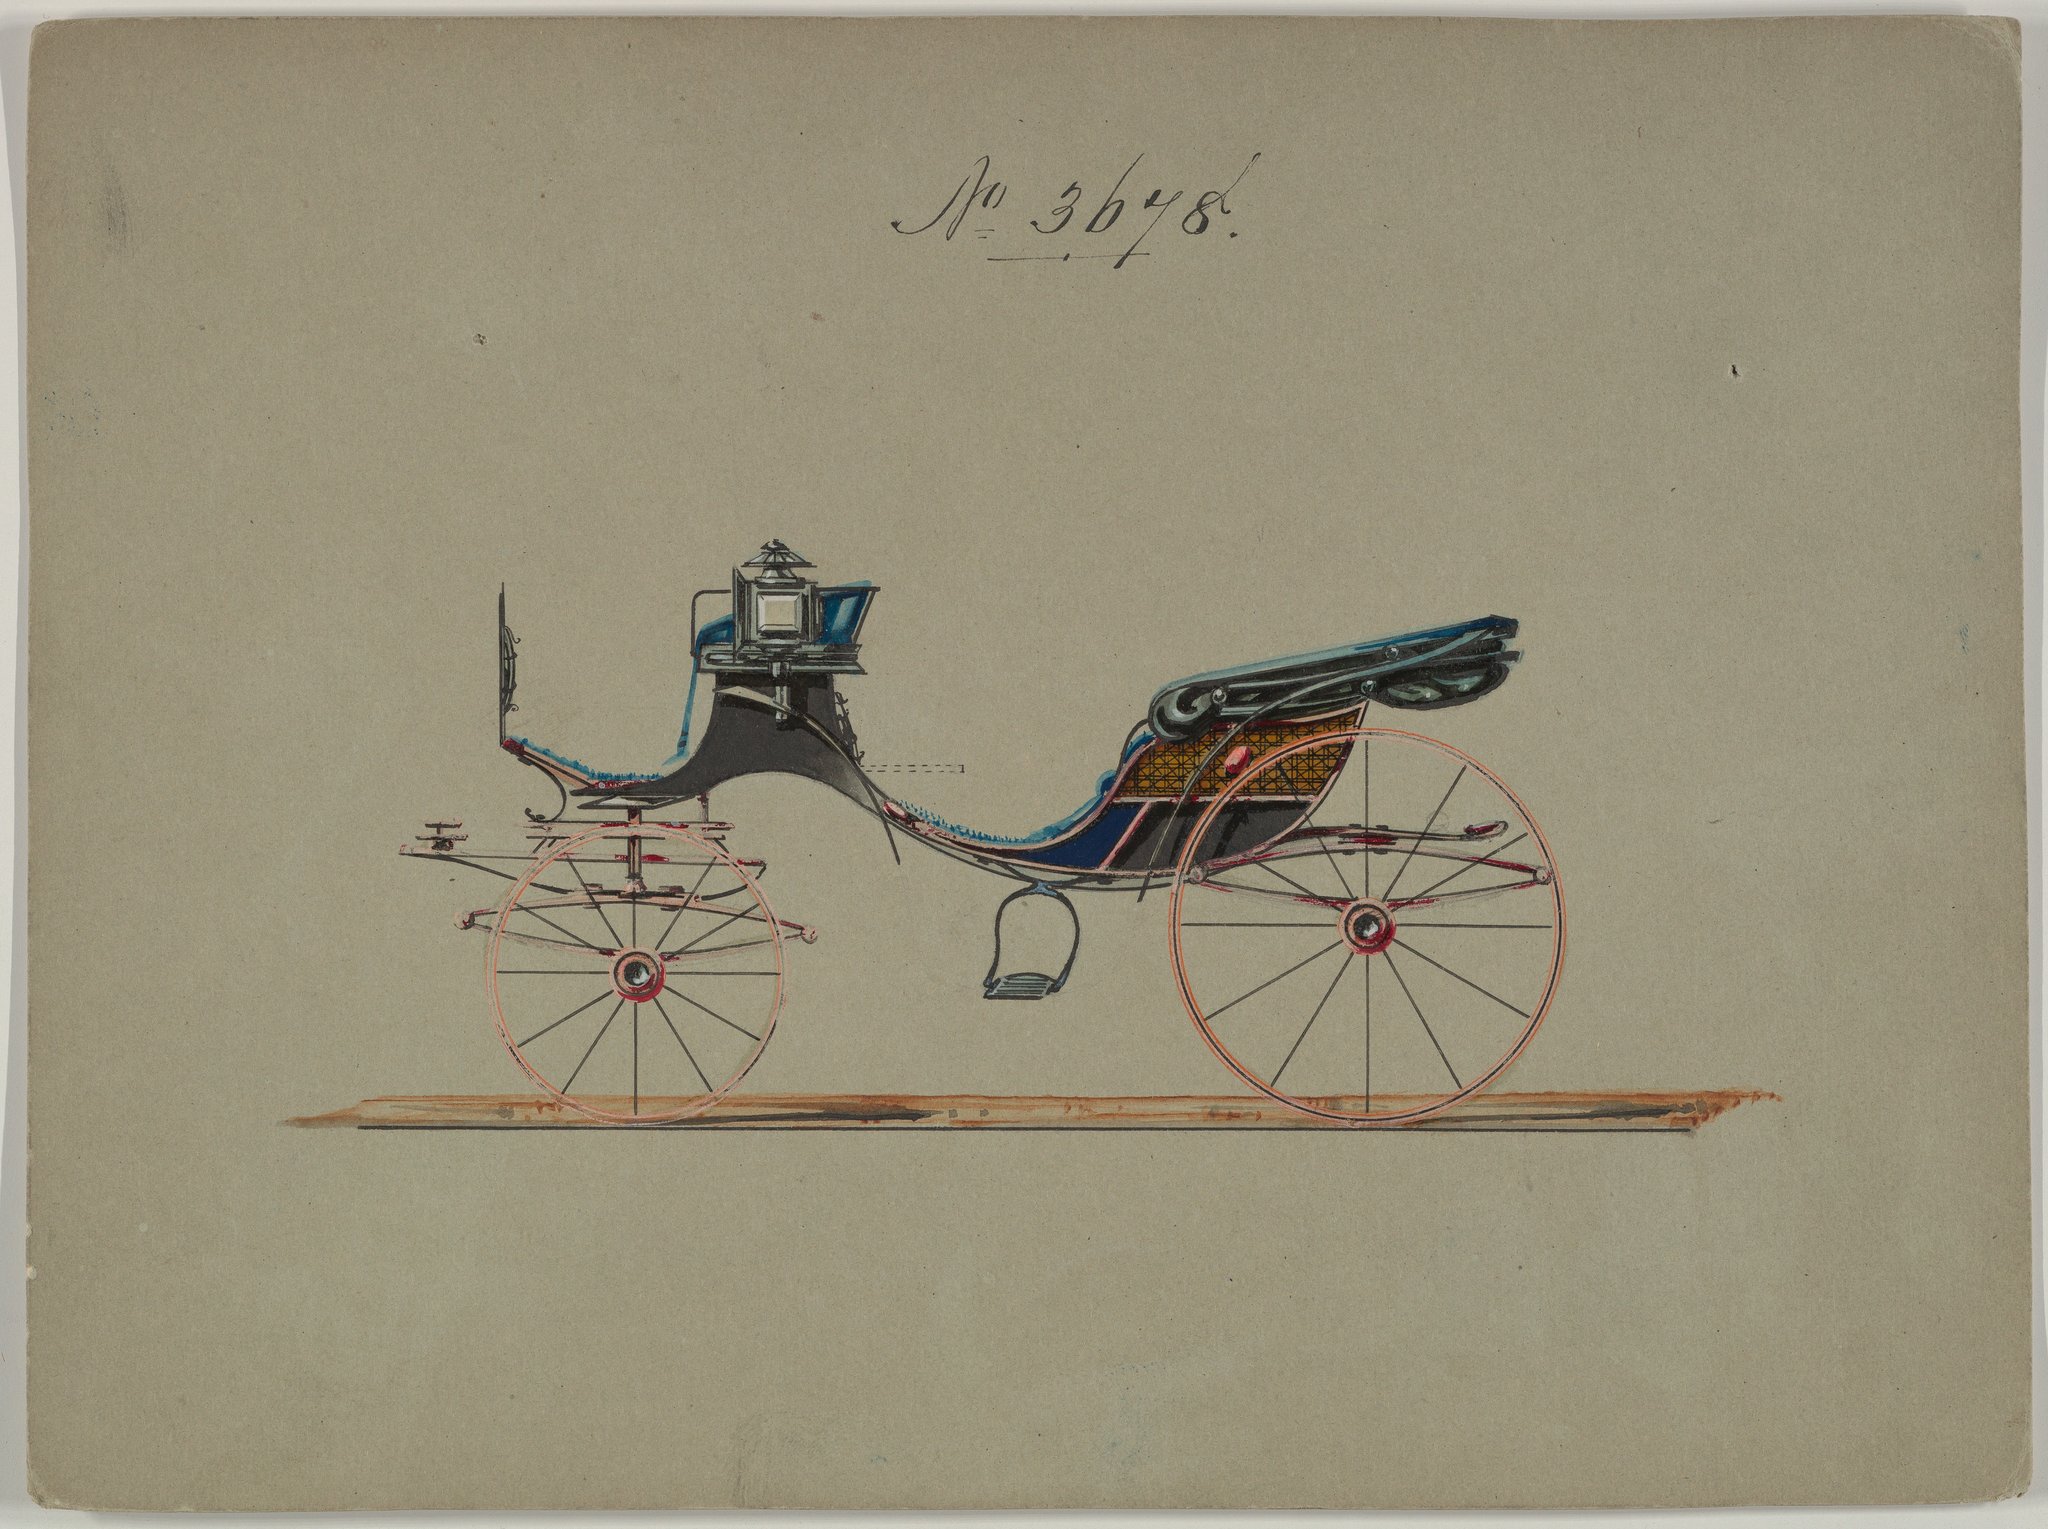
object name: drawing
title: Design for Cabriolet or Victoria, no. 3678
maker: brewster & co.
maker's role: manufacturer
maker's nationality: american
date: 1881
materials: gouache, gum arabic, ink, watercolor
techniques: pen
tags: carriages